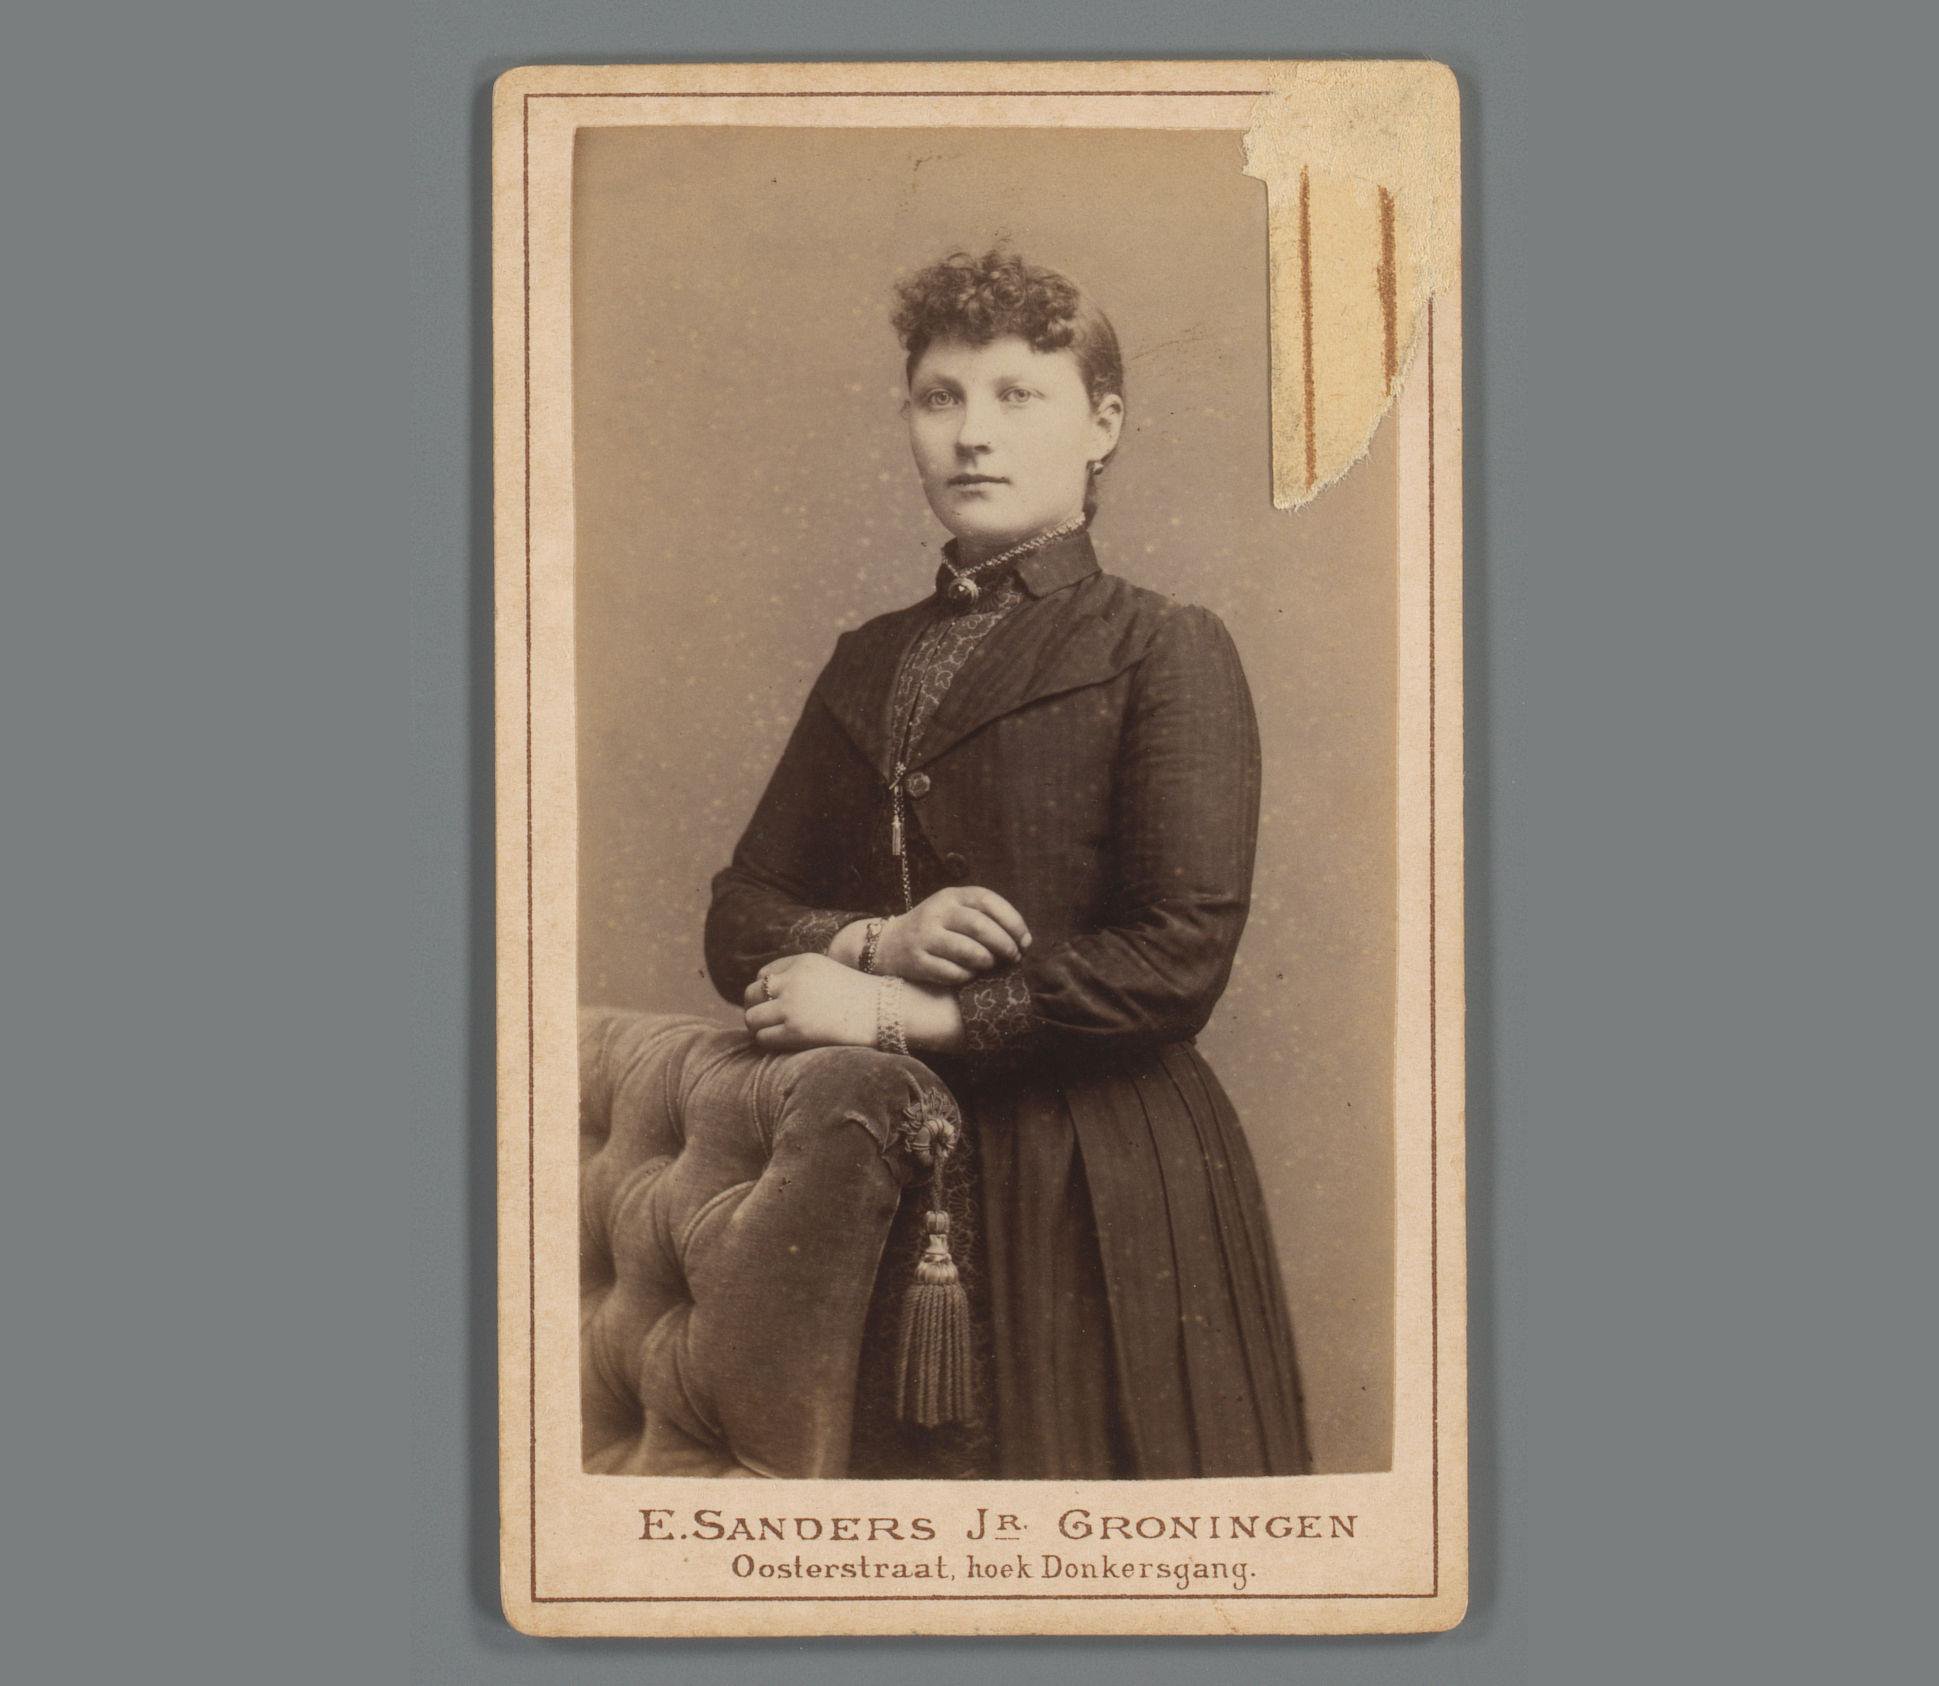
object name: carte de visite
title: Portret van Gezina Scharringa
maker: elkan sanders jr.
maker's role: fotograaf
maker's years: 1848-1932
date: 1886-1891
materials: cardboard, paper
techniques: albumen print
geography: groningen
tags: historical persons - bb - woman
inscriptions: inscription: ‘Vergrootingen naar ieder portret/ Elkan Sanders Jr./ GRONINGEN/ Oosterstraat 204./ Hoek Donkersgang./ Muster geschützt WW.29.’, inscription: ‘Gezina Scharringa’